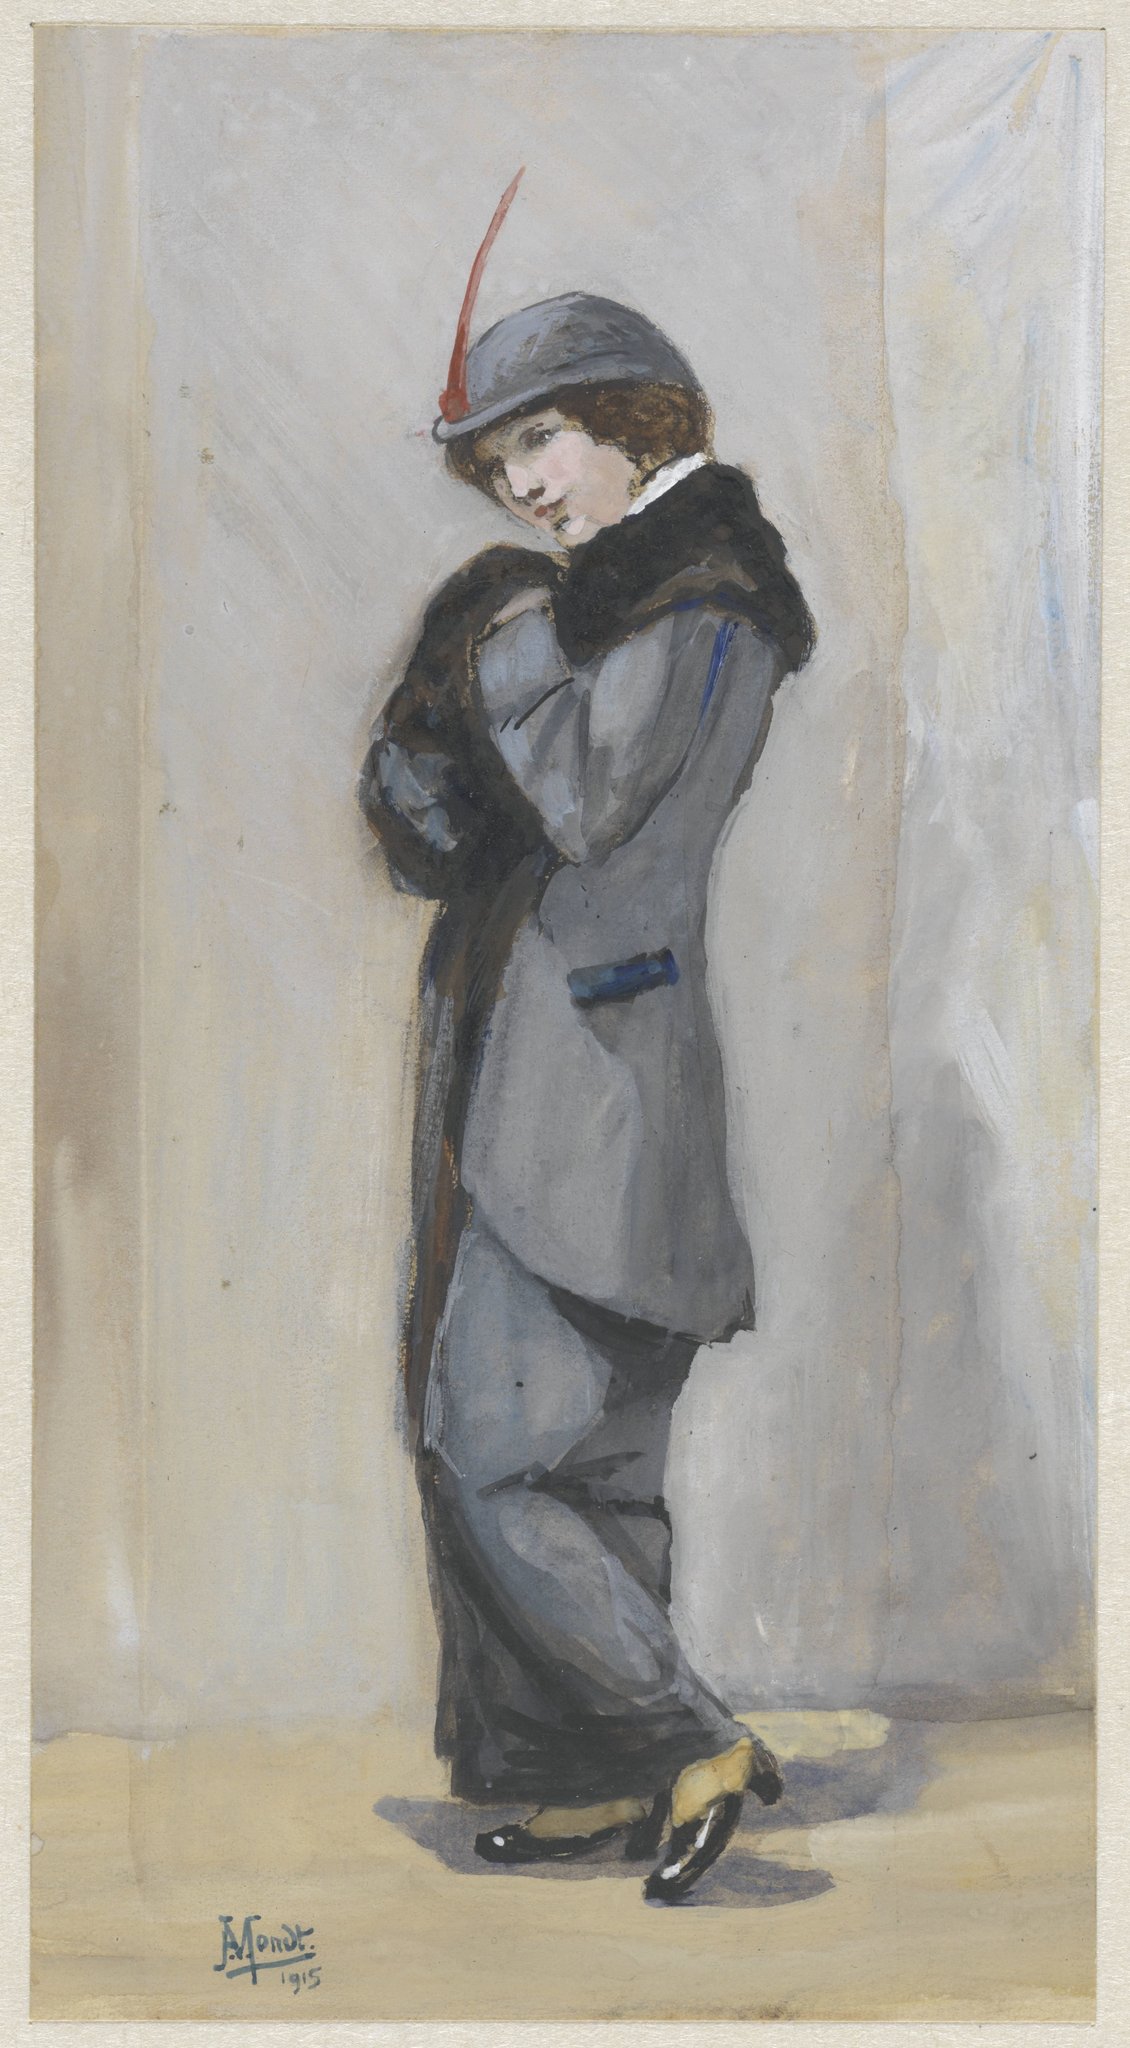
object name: drawing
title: Staande dame in lange mantel met bont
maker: johannes abraham mondt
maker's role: draughtsman, print maker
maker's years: 1859-1941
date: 1915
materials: paint, gouache, paper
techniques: brush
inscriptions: date: ‘1915’